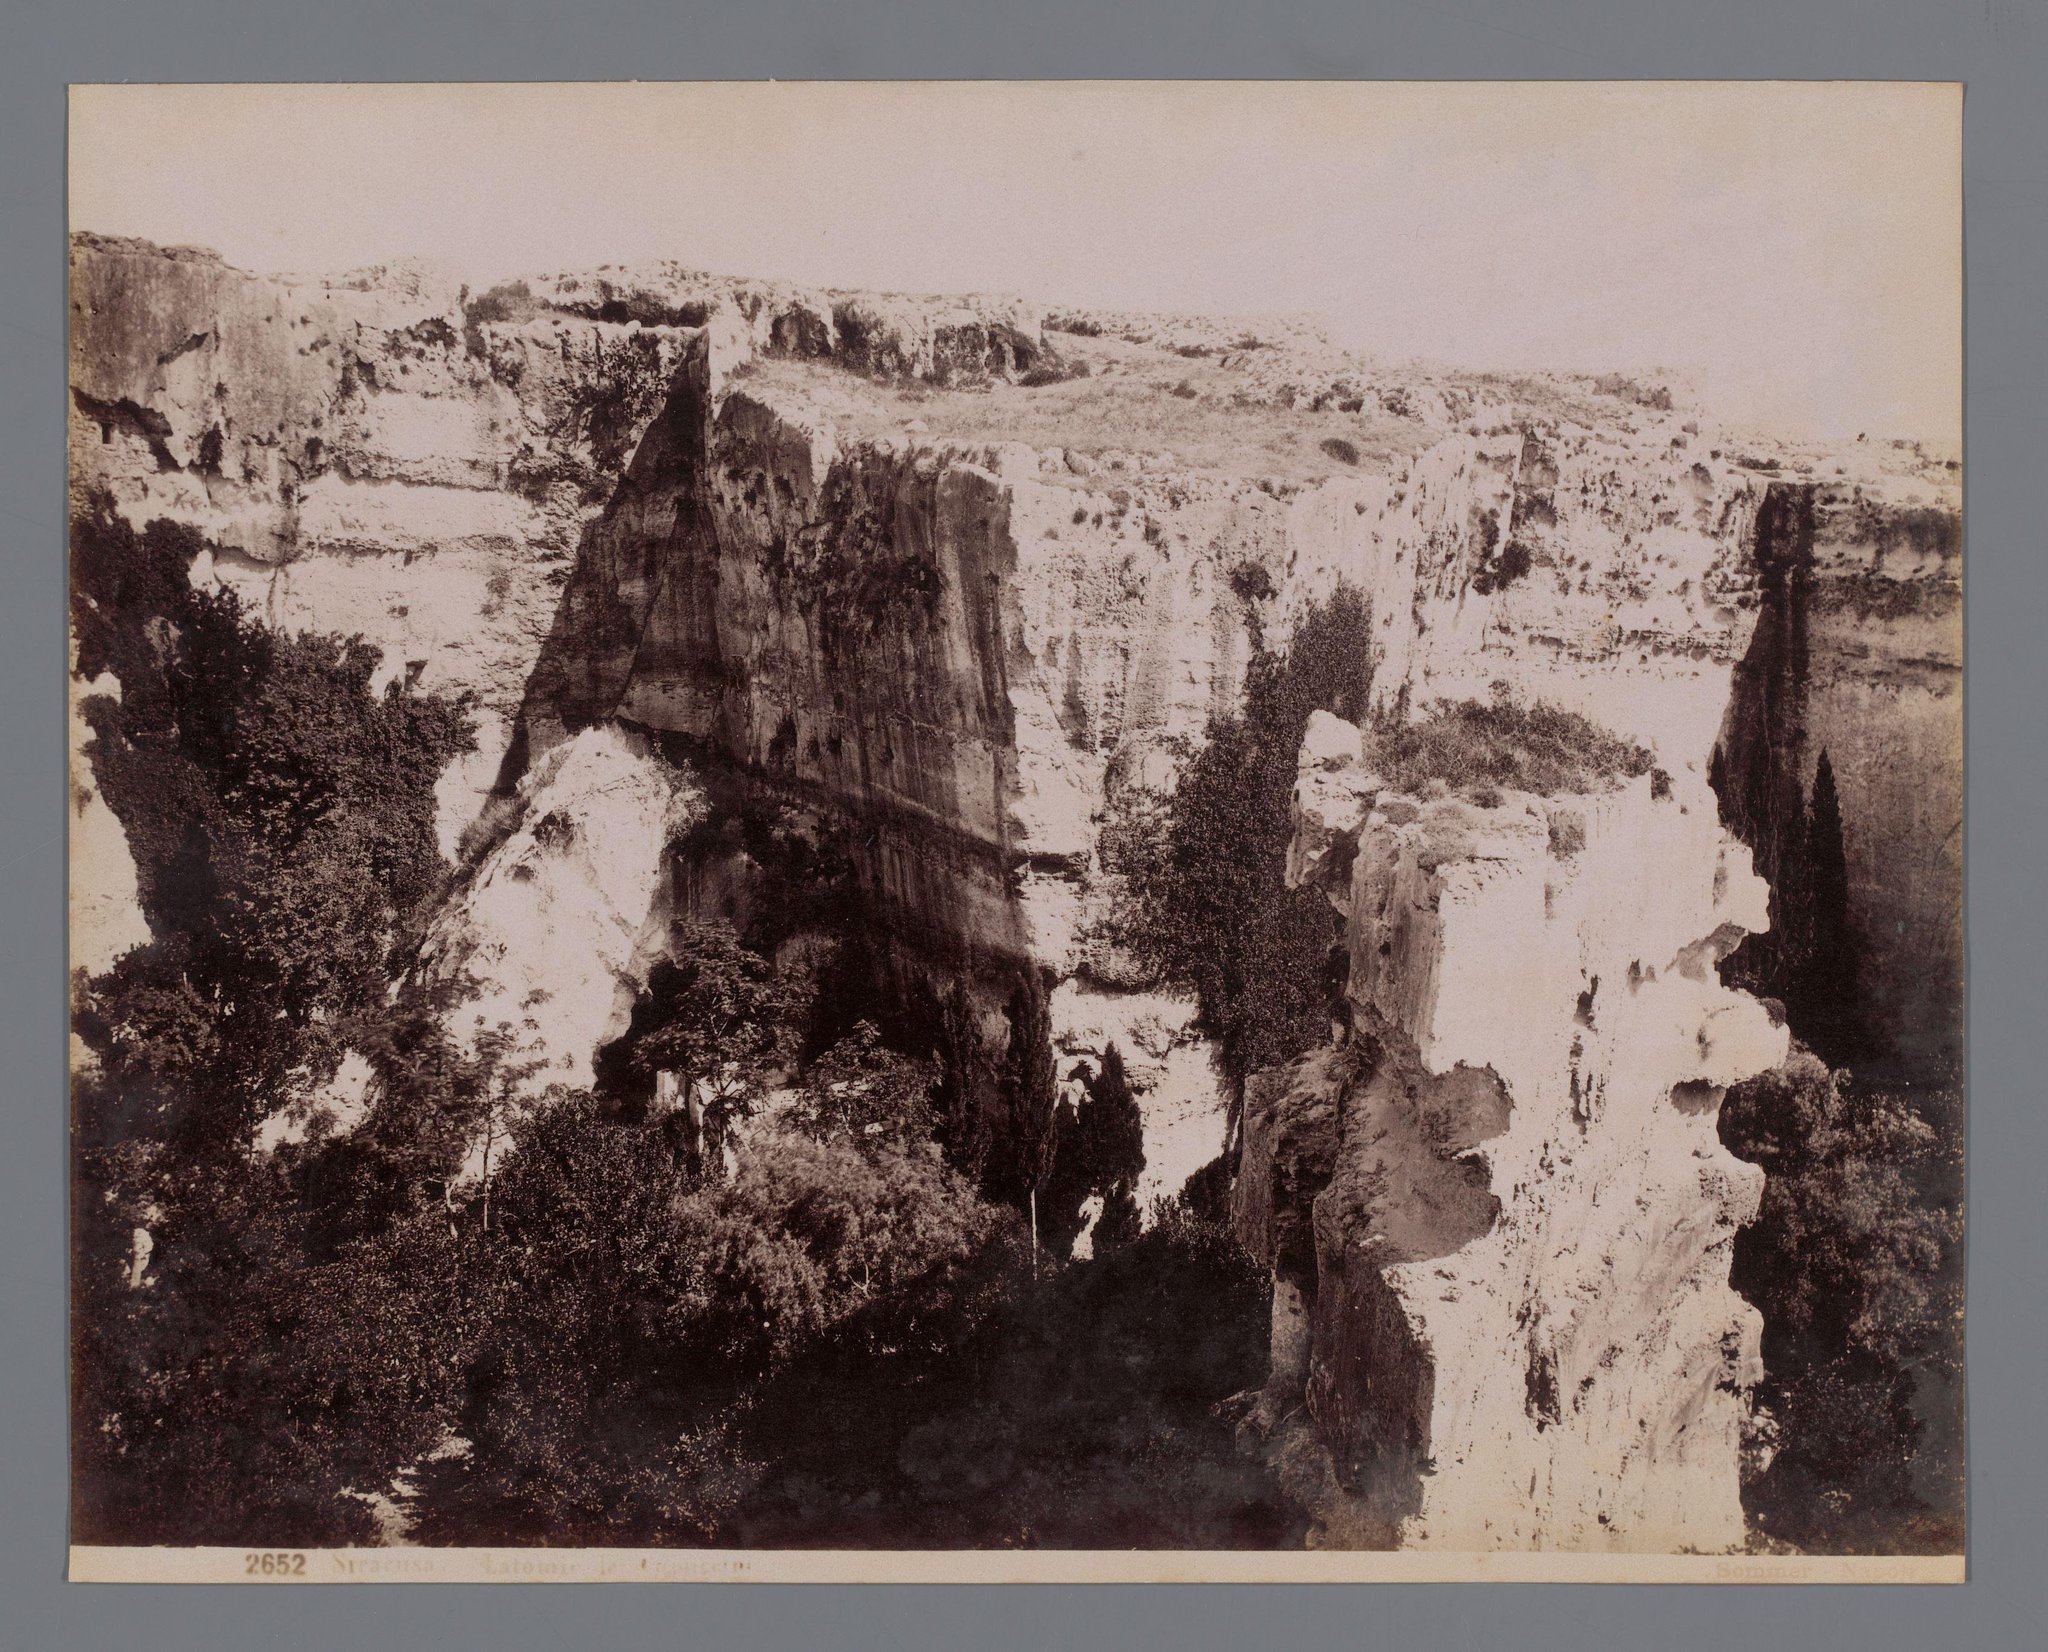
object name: photograph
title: Latomie del Paradiso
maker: giorgio sommer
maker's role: fotograaf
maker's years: 1834-1914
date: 1857-1914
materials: cardboard, paper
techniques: albumen print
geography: syracuse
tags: quarry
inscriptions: number: ‘2652’